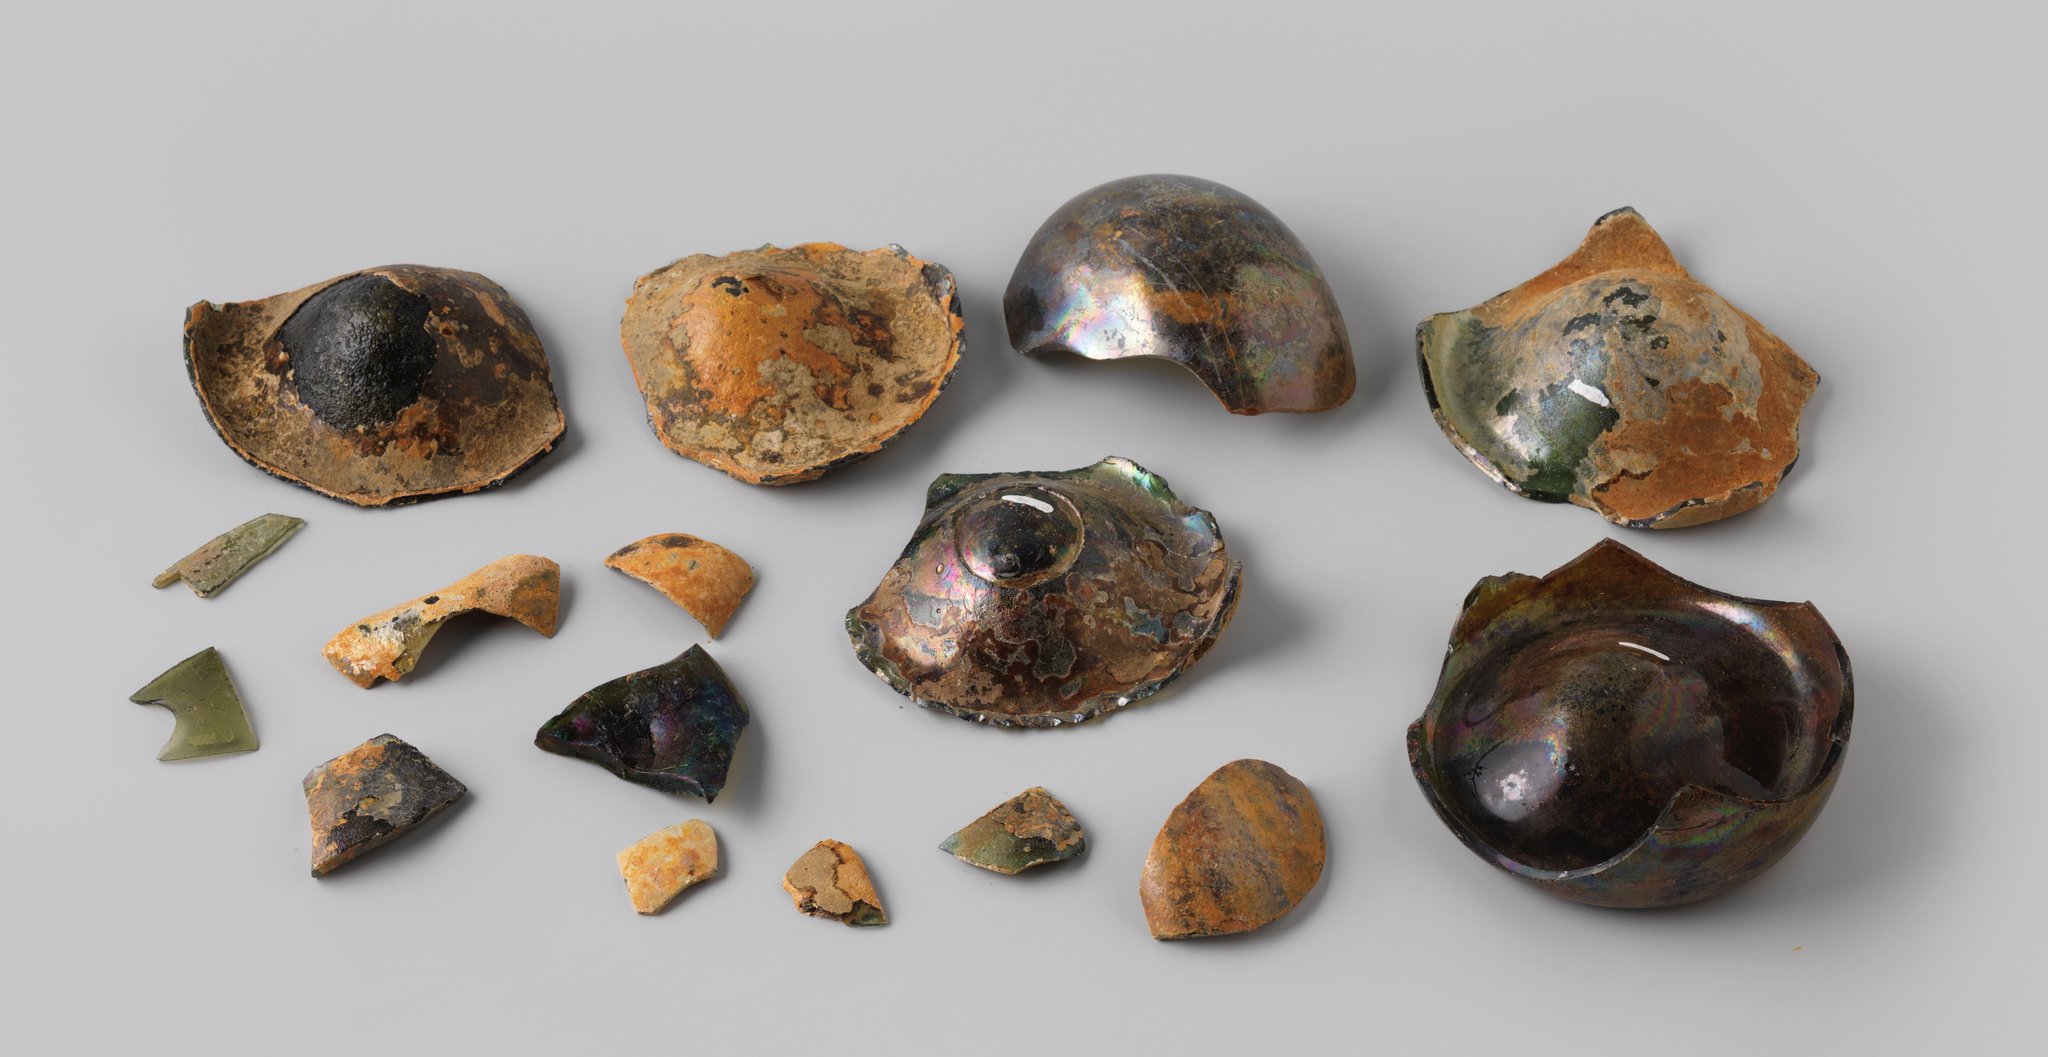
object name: sherd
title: Scherven van wijnflessen uit het wrak van de Oost-Indiëvaarder 't Vliegend Hart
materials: glass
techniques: green glass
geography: netherlands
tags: 't vliegend hart (schip), verenigde oostindische compagnie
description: Scherven van uivormige wijnflessen van groen glas waar rode (port)wijn in heeft gezeten.